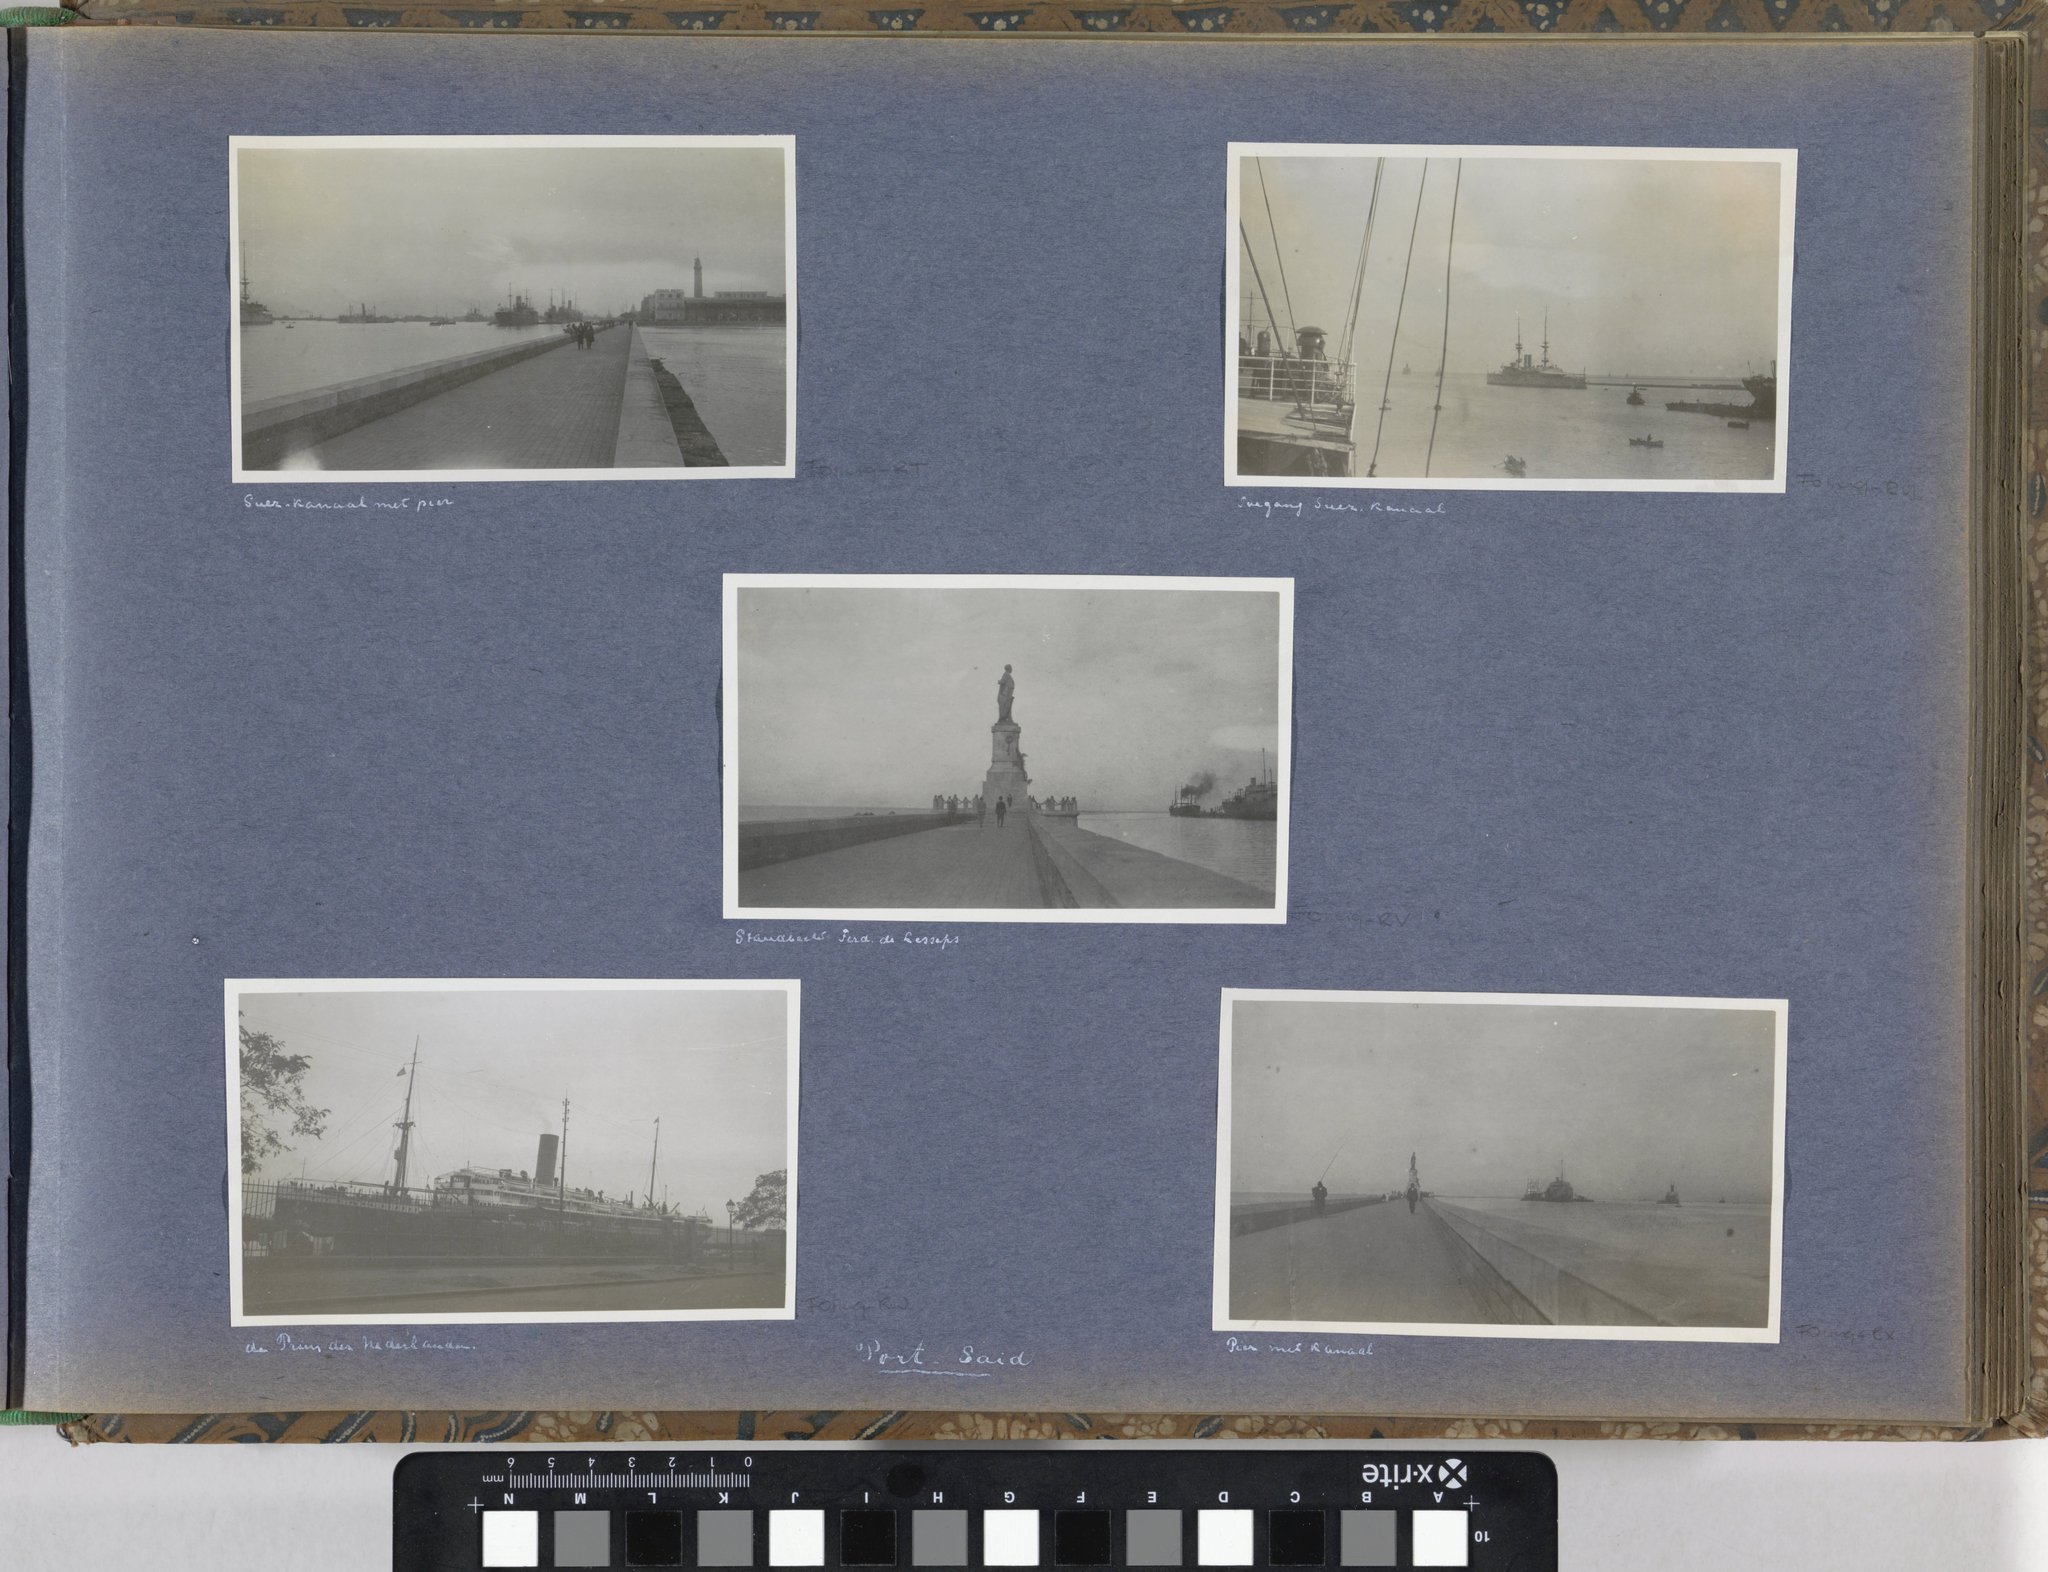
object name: photograph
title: Schepen bij de ingang van het Suezkanaal in Port Said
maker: Anonymous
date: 1900-1920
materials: paper, photographic support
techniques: gelatin silver print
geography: port said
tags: canal, steamship, motorship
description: Onderdeel van reisalbum met foto's van bedrijvigheid en bezienswaardigheden op Sumatra en Java en van de reis naar en van Nederlands-Indië.